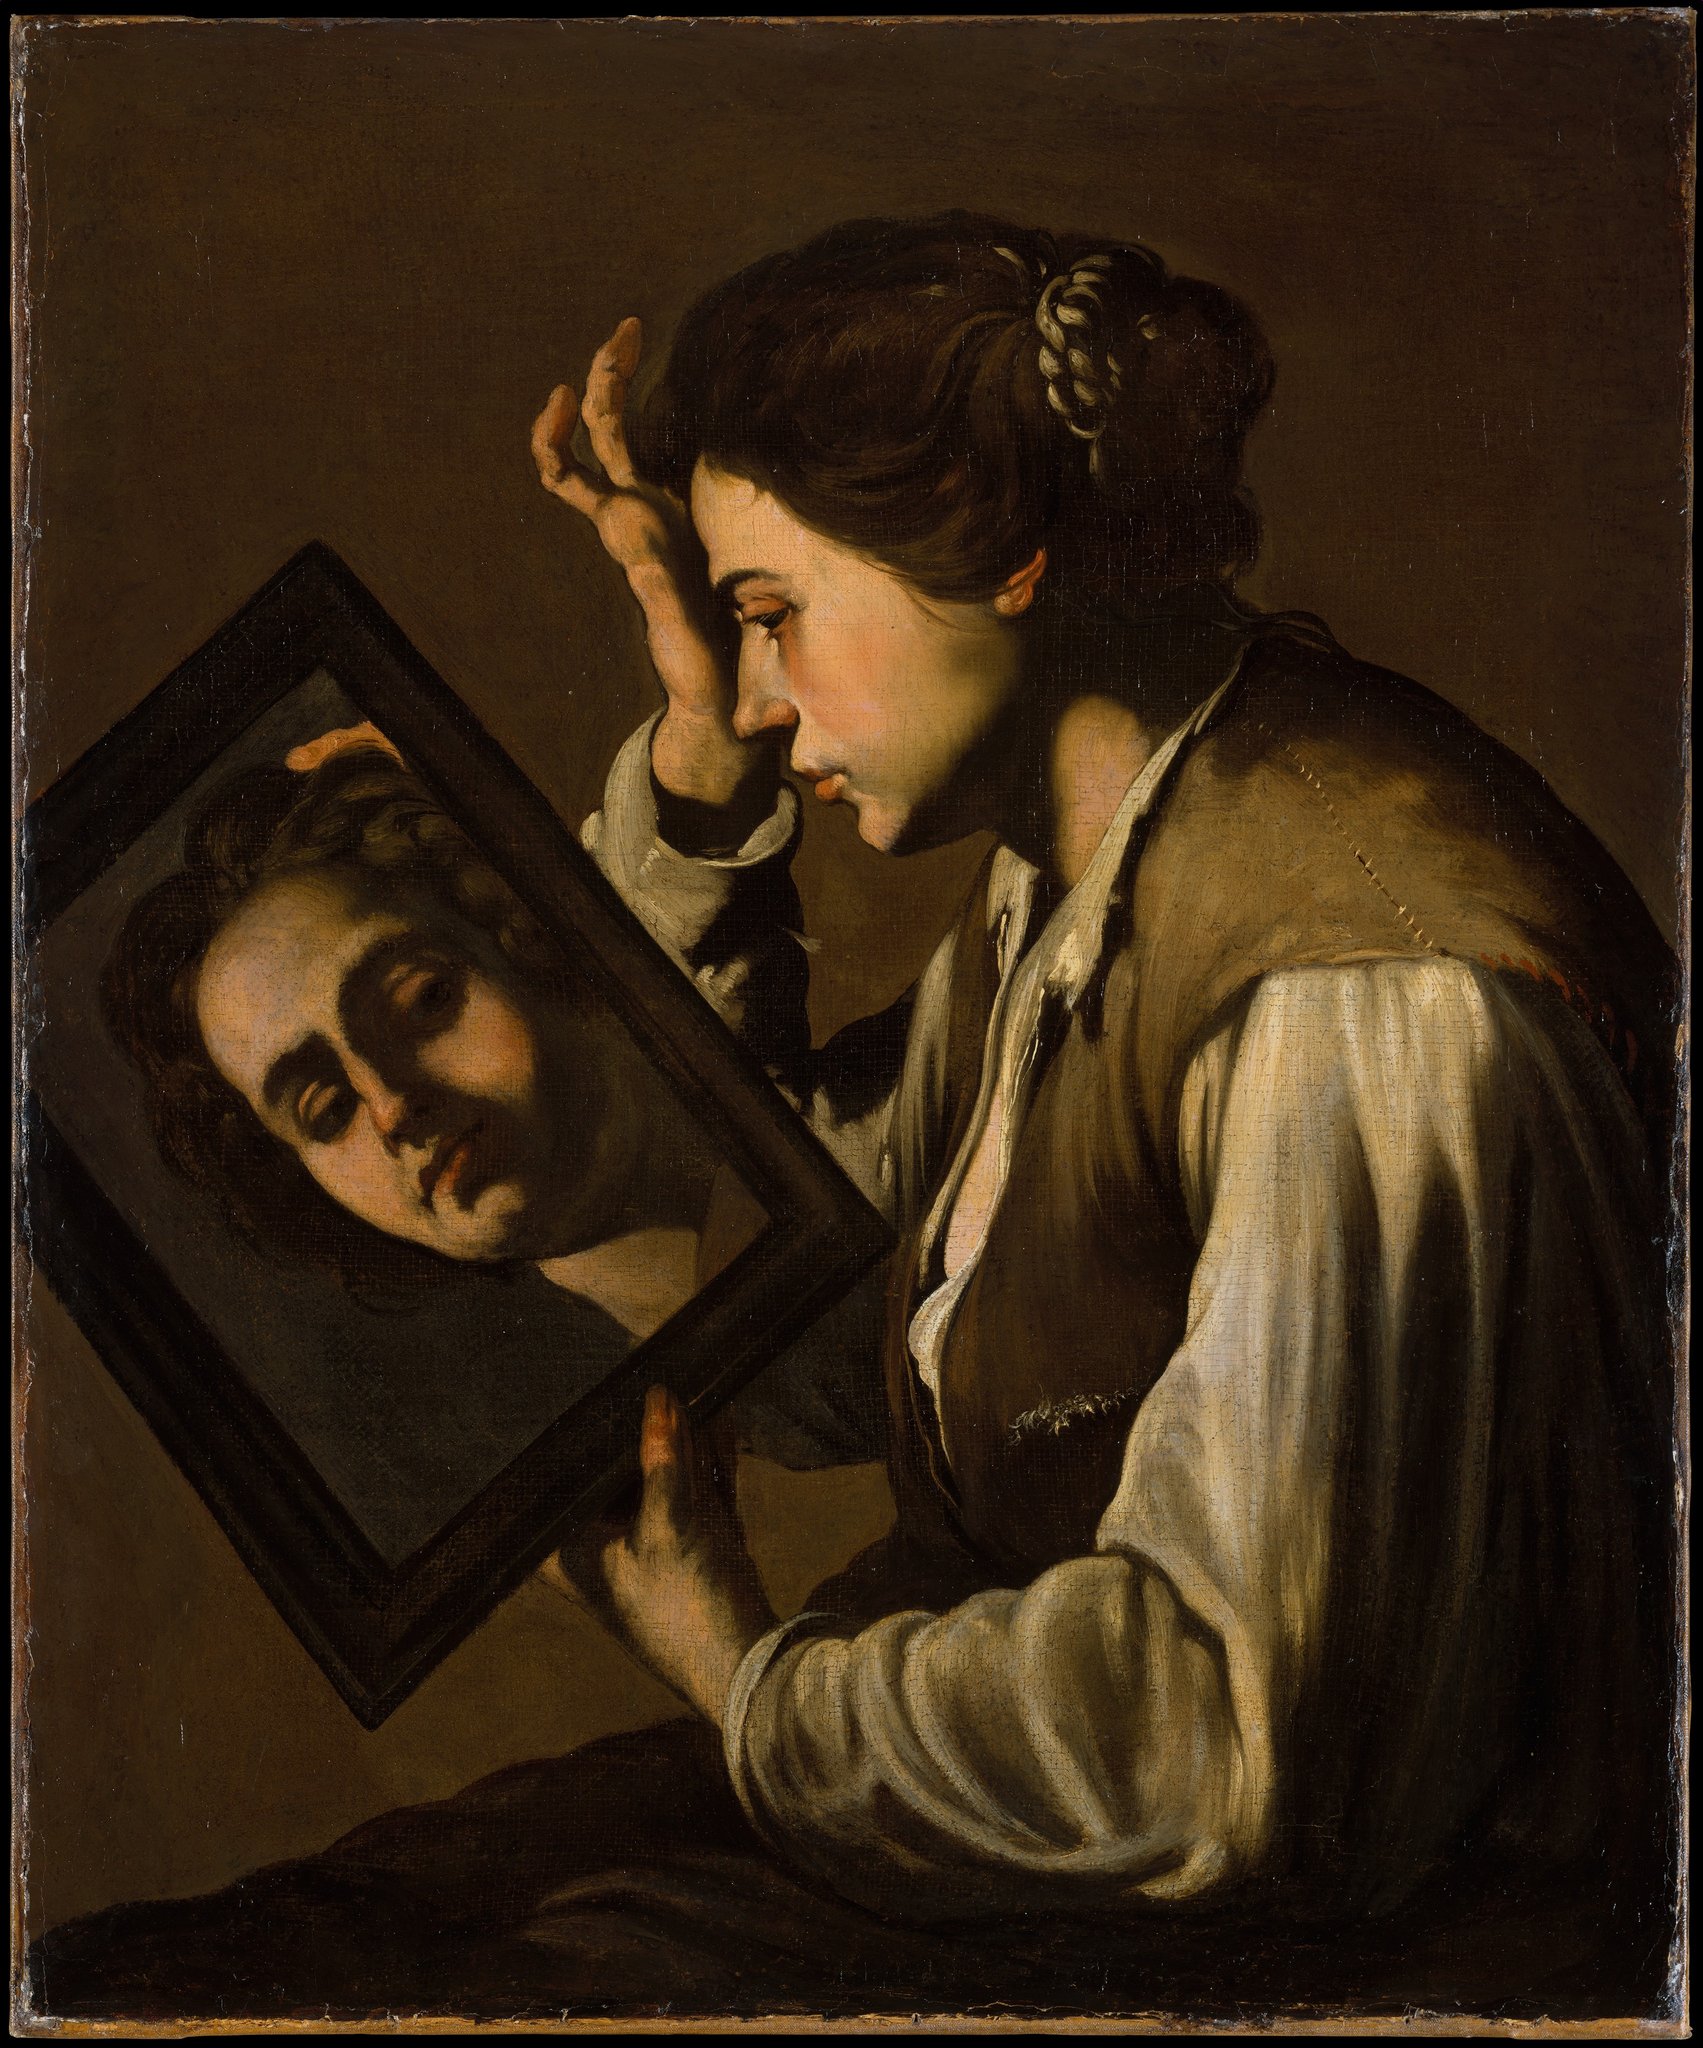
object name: painting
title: The Sense of Sight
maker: master of the annunciation to the shepherds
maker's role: artist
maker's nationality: italian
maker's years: 1615-1645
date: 1625-1649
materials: canvas, oil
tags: women,mirrors